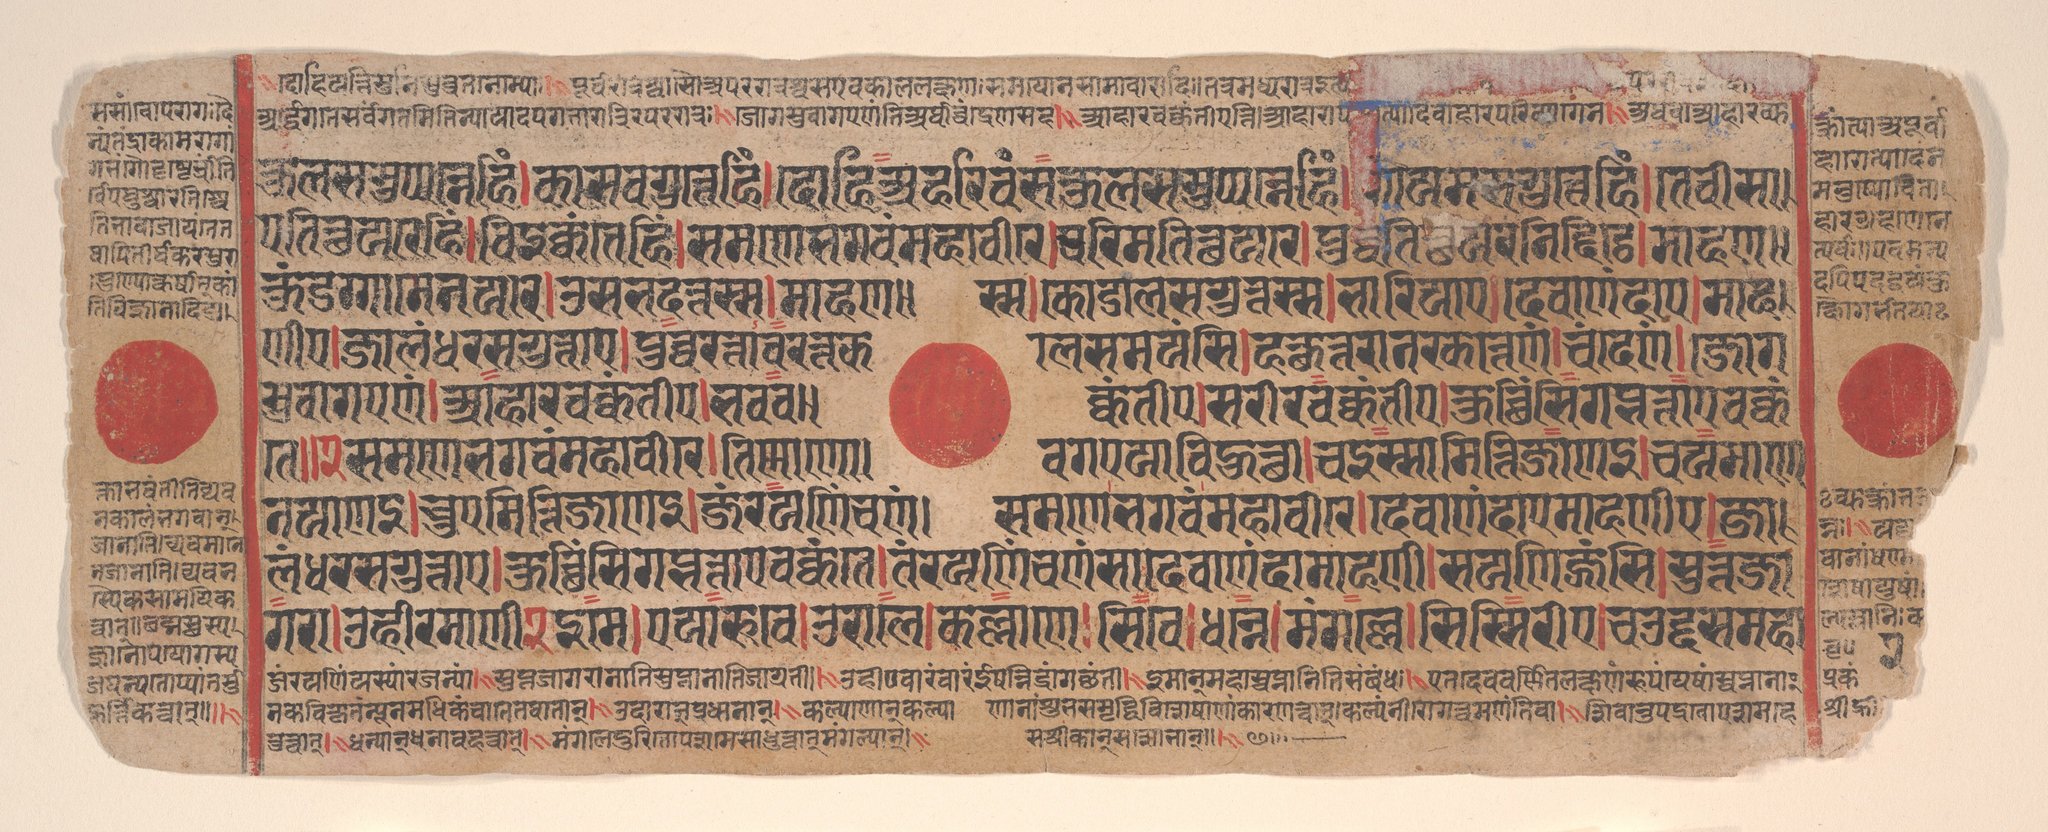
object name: folio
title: Leaf from a Kalpa Sutra (Jain Book of Rituals)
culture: indian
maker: bhadrabahu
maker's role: artist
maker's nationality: indian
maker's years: 356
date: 1401-1500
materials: gold, ink, paper, watercolor